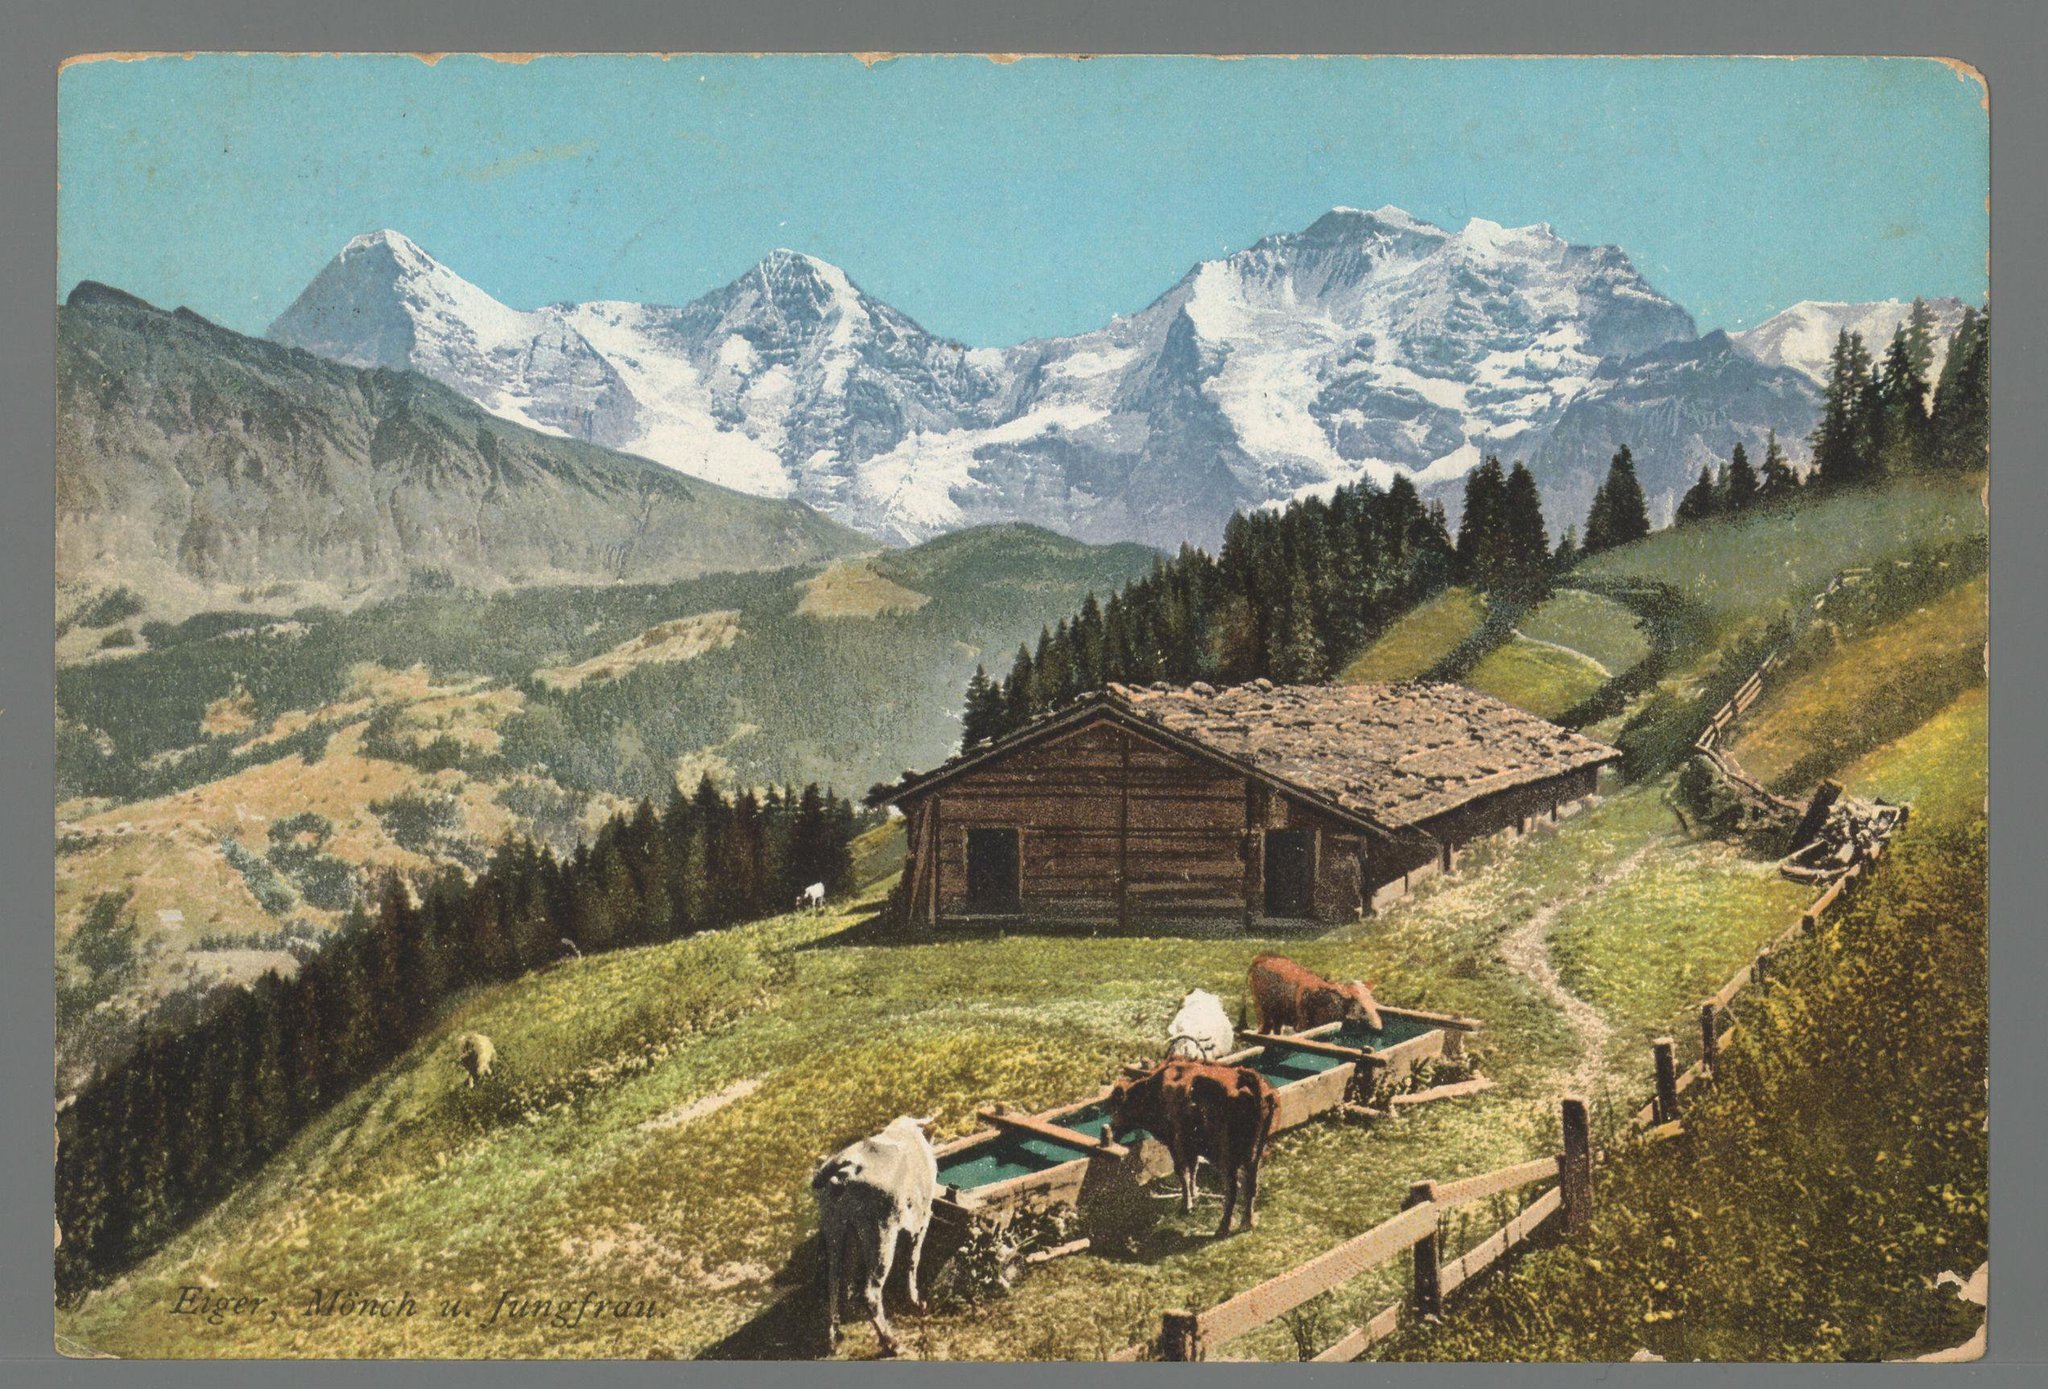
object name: photomechanical print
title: Eiger, Mönch u. Jungfrau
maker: Anonymous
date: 1905-1911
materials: cardboard, photographic process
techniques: writing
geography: interlaken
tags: cow, mountain-range, snow peaks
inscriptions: postage stamp